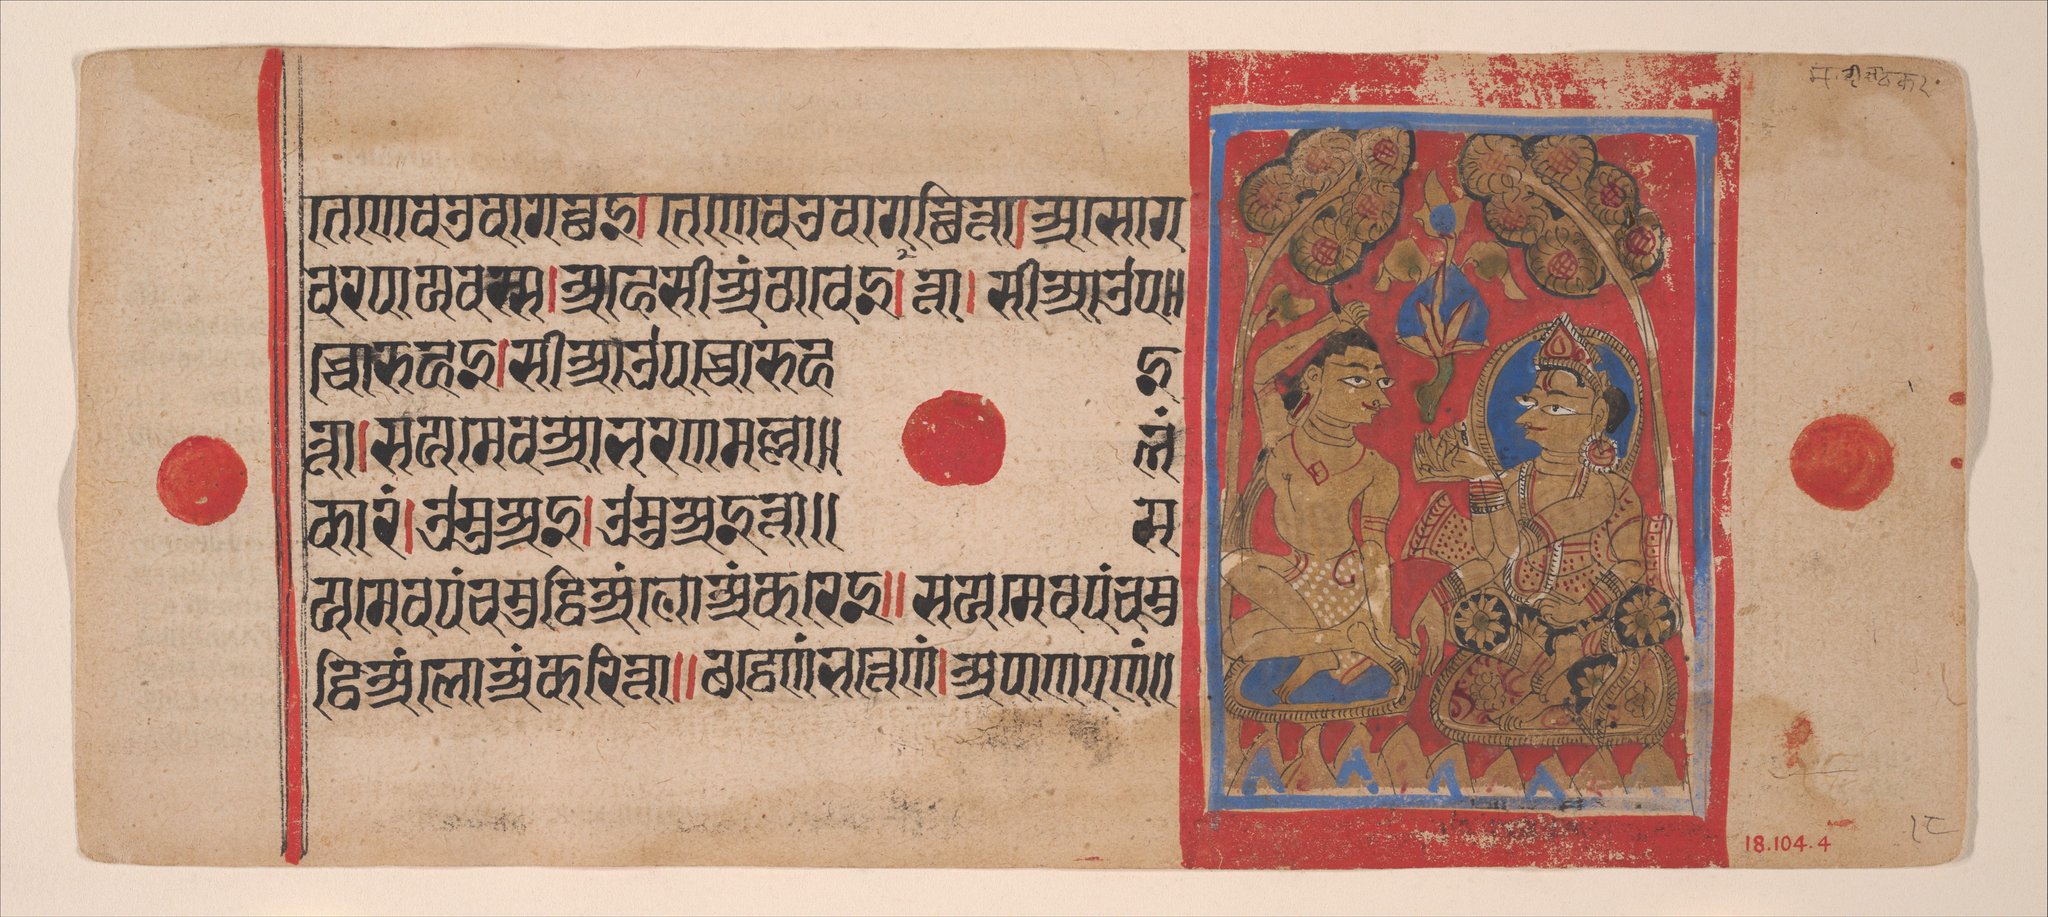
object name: manuscript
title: Tonsure of Mahavira: Folio from a Kalpasutra Manuscript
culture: indian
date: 1461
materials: gold, ink, paper, watercolor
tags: men